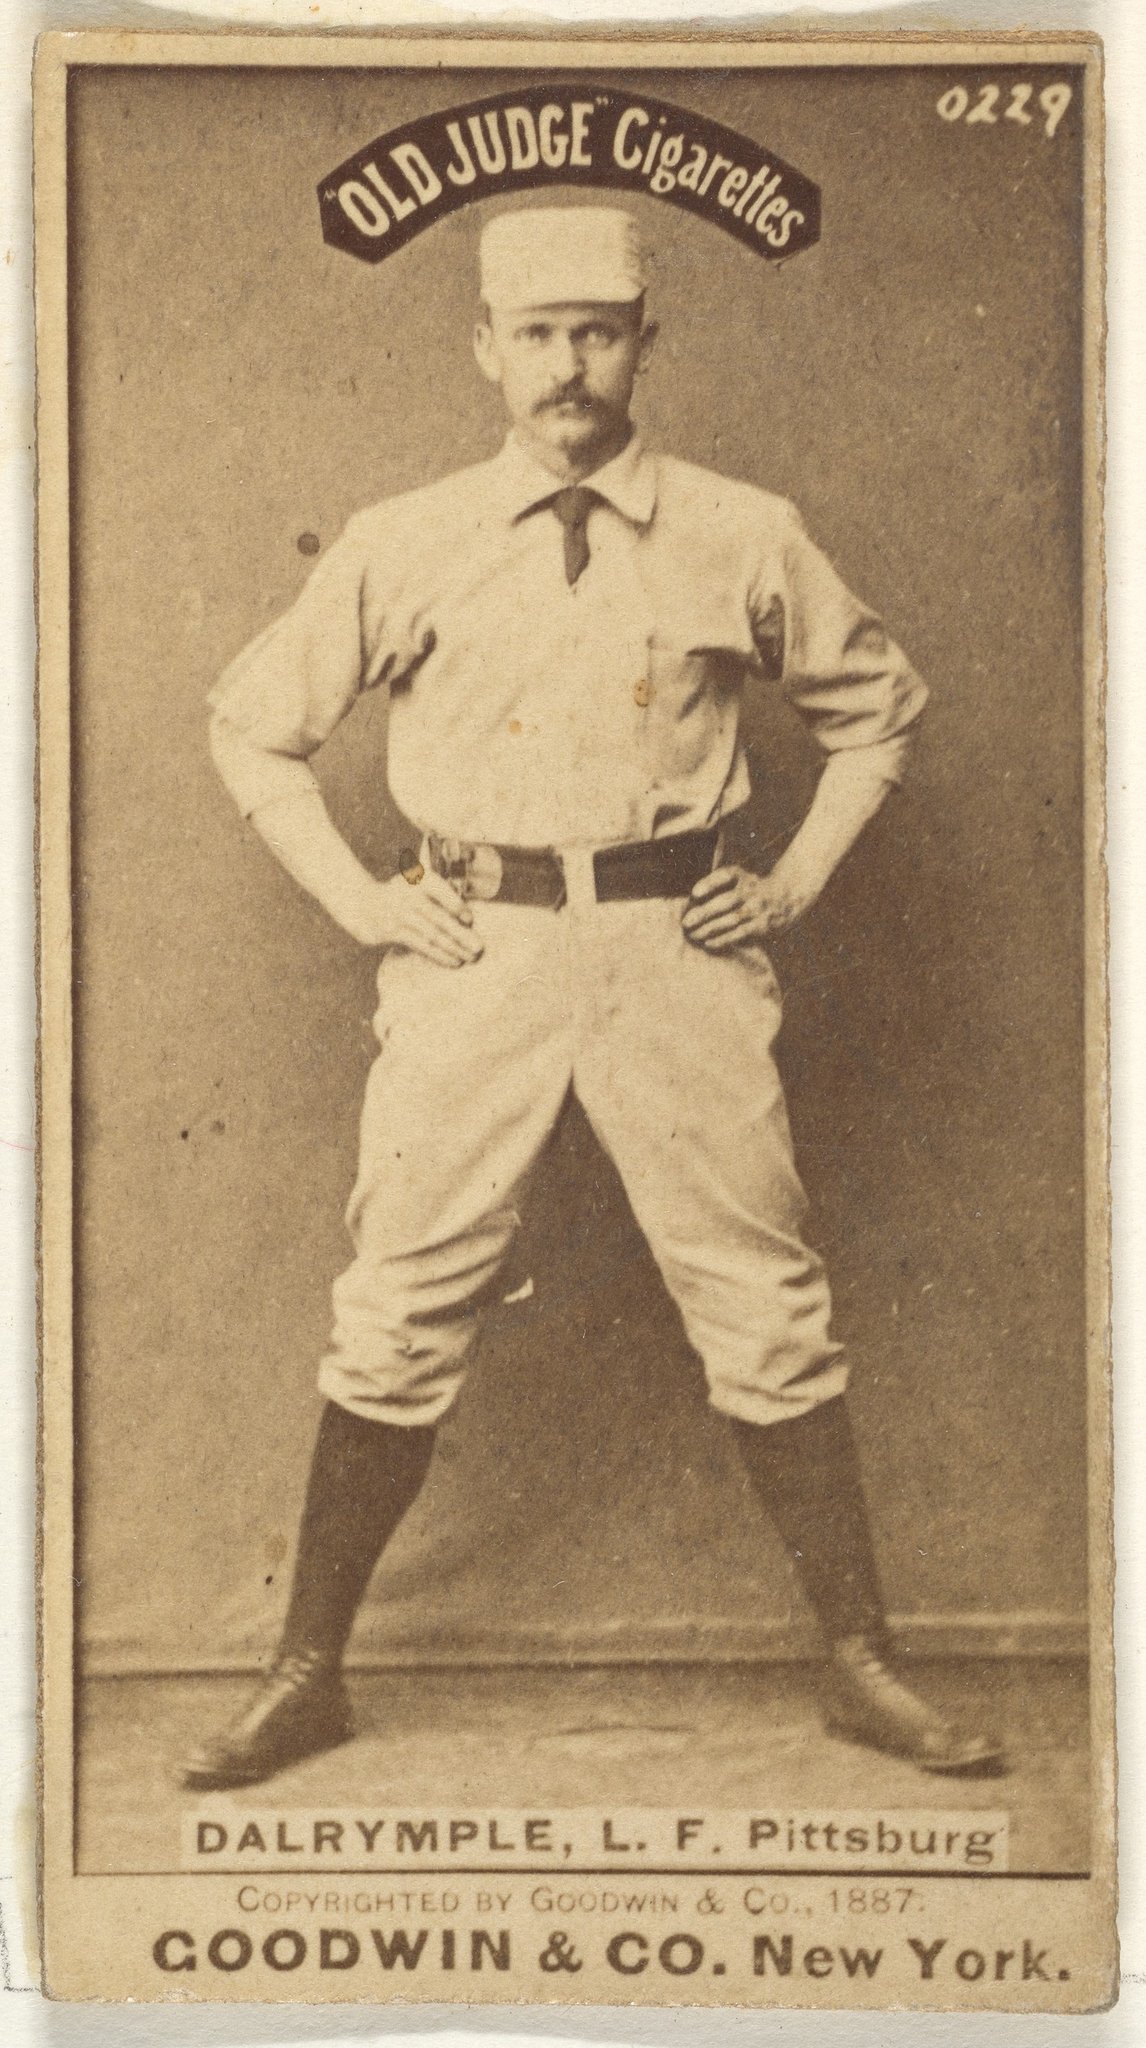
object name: baseball card, photograph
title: Abner Frank Dalrymple, Left Field, Pittsburgh, from the Old Judge series (N172) for Old Judge Cigarettes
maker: goodwin & company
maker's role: publisher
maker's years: 1850-1950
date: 1887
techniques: albumen silver print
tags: men,portraits,baseball,athletes